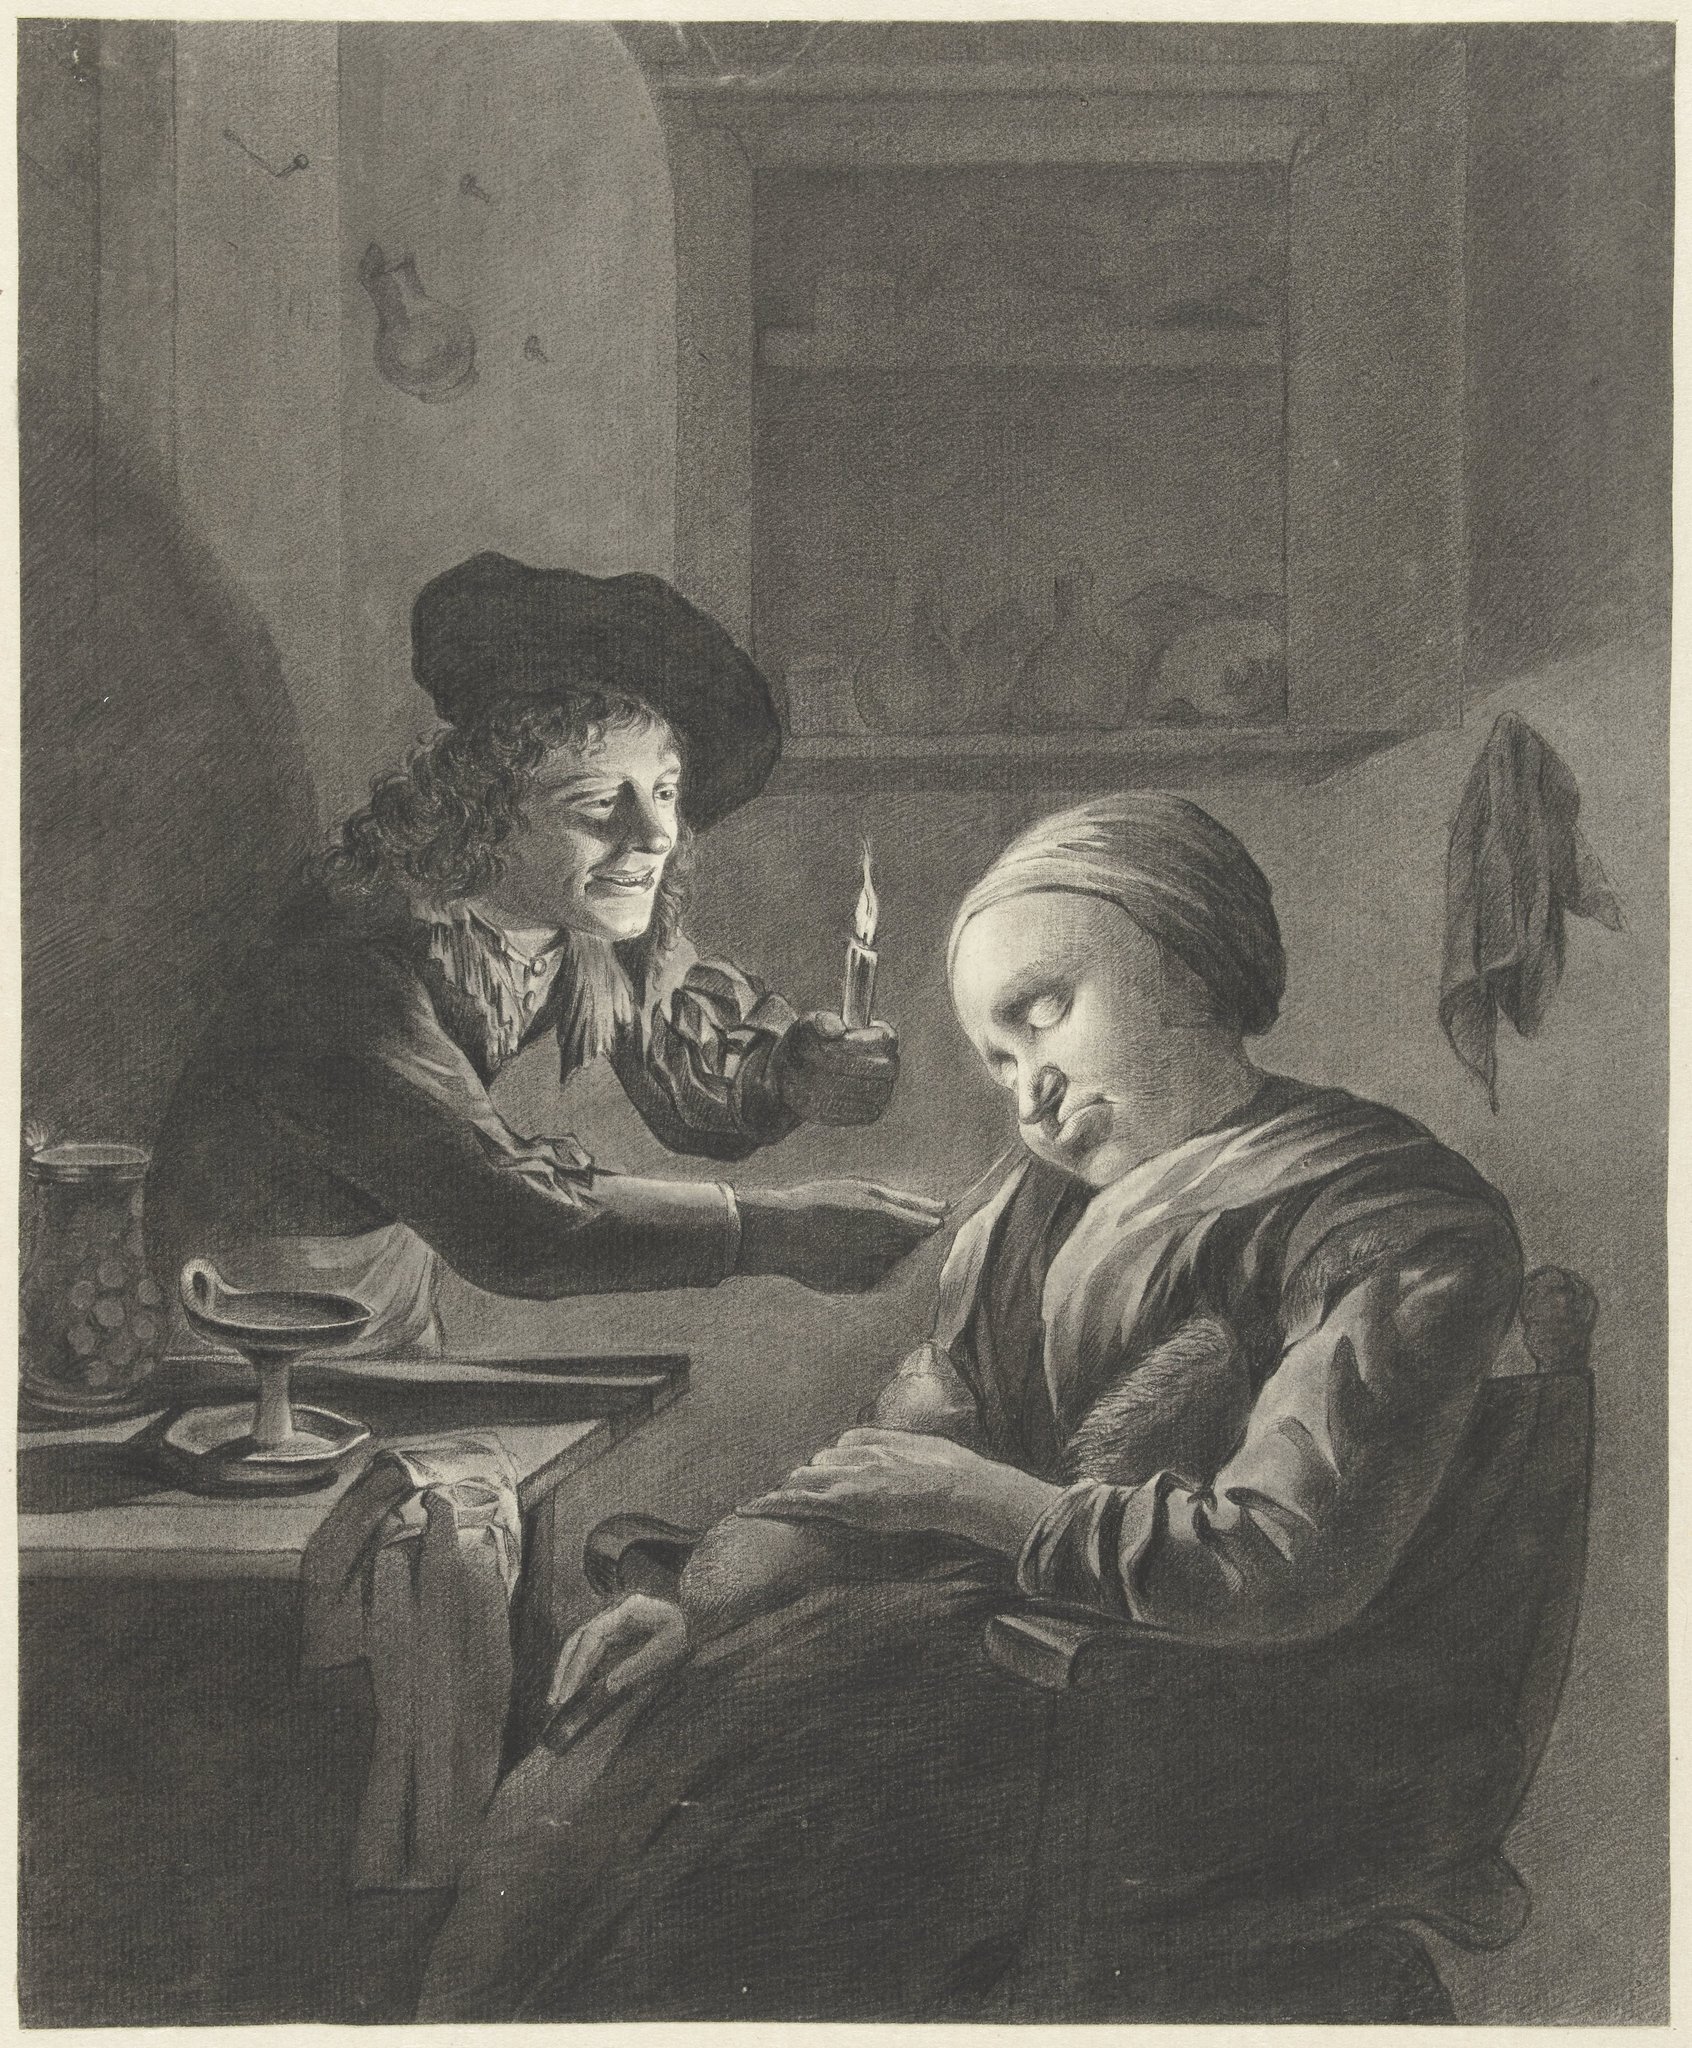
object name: drawing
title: Man met kaars kietelt een slapende vrouw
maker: j. dillhoff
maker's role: draughtsman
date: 1747-1767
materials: chalk, paper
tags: sleeping; unconsciousness